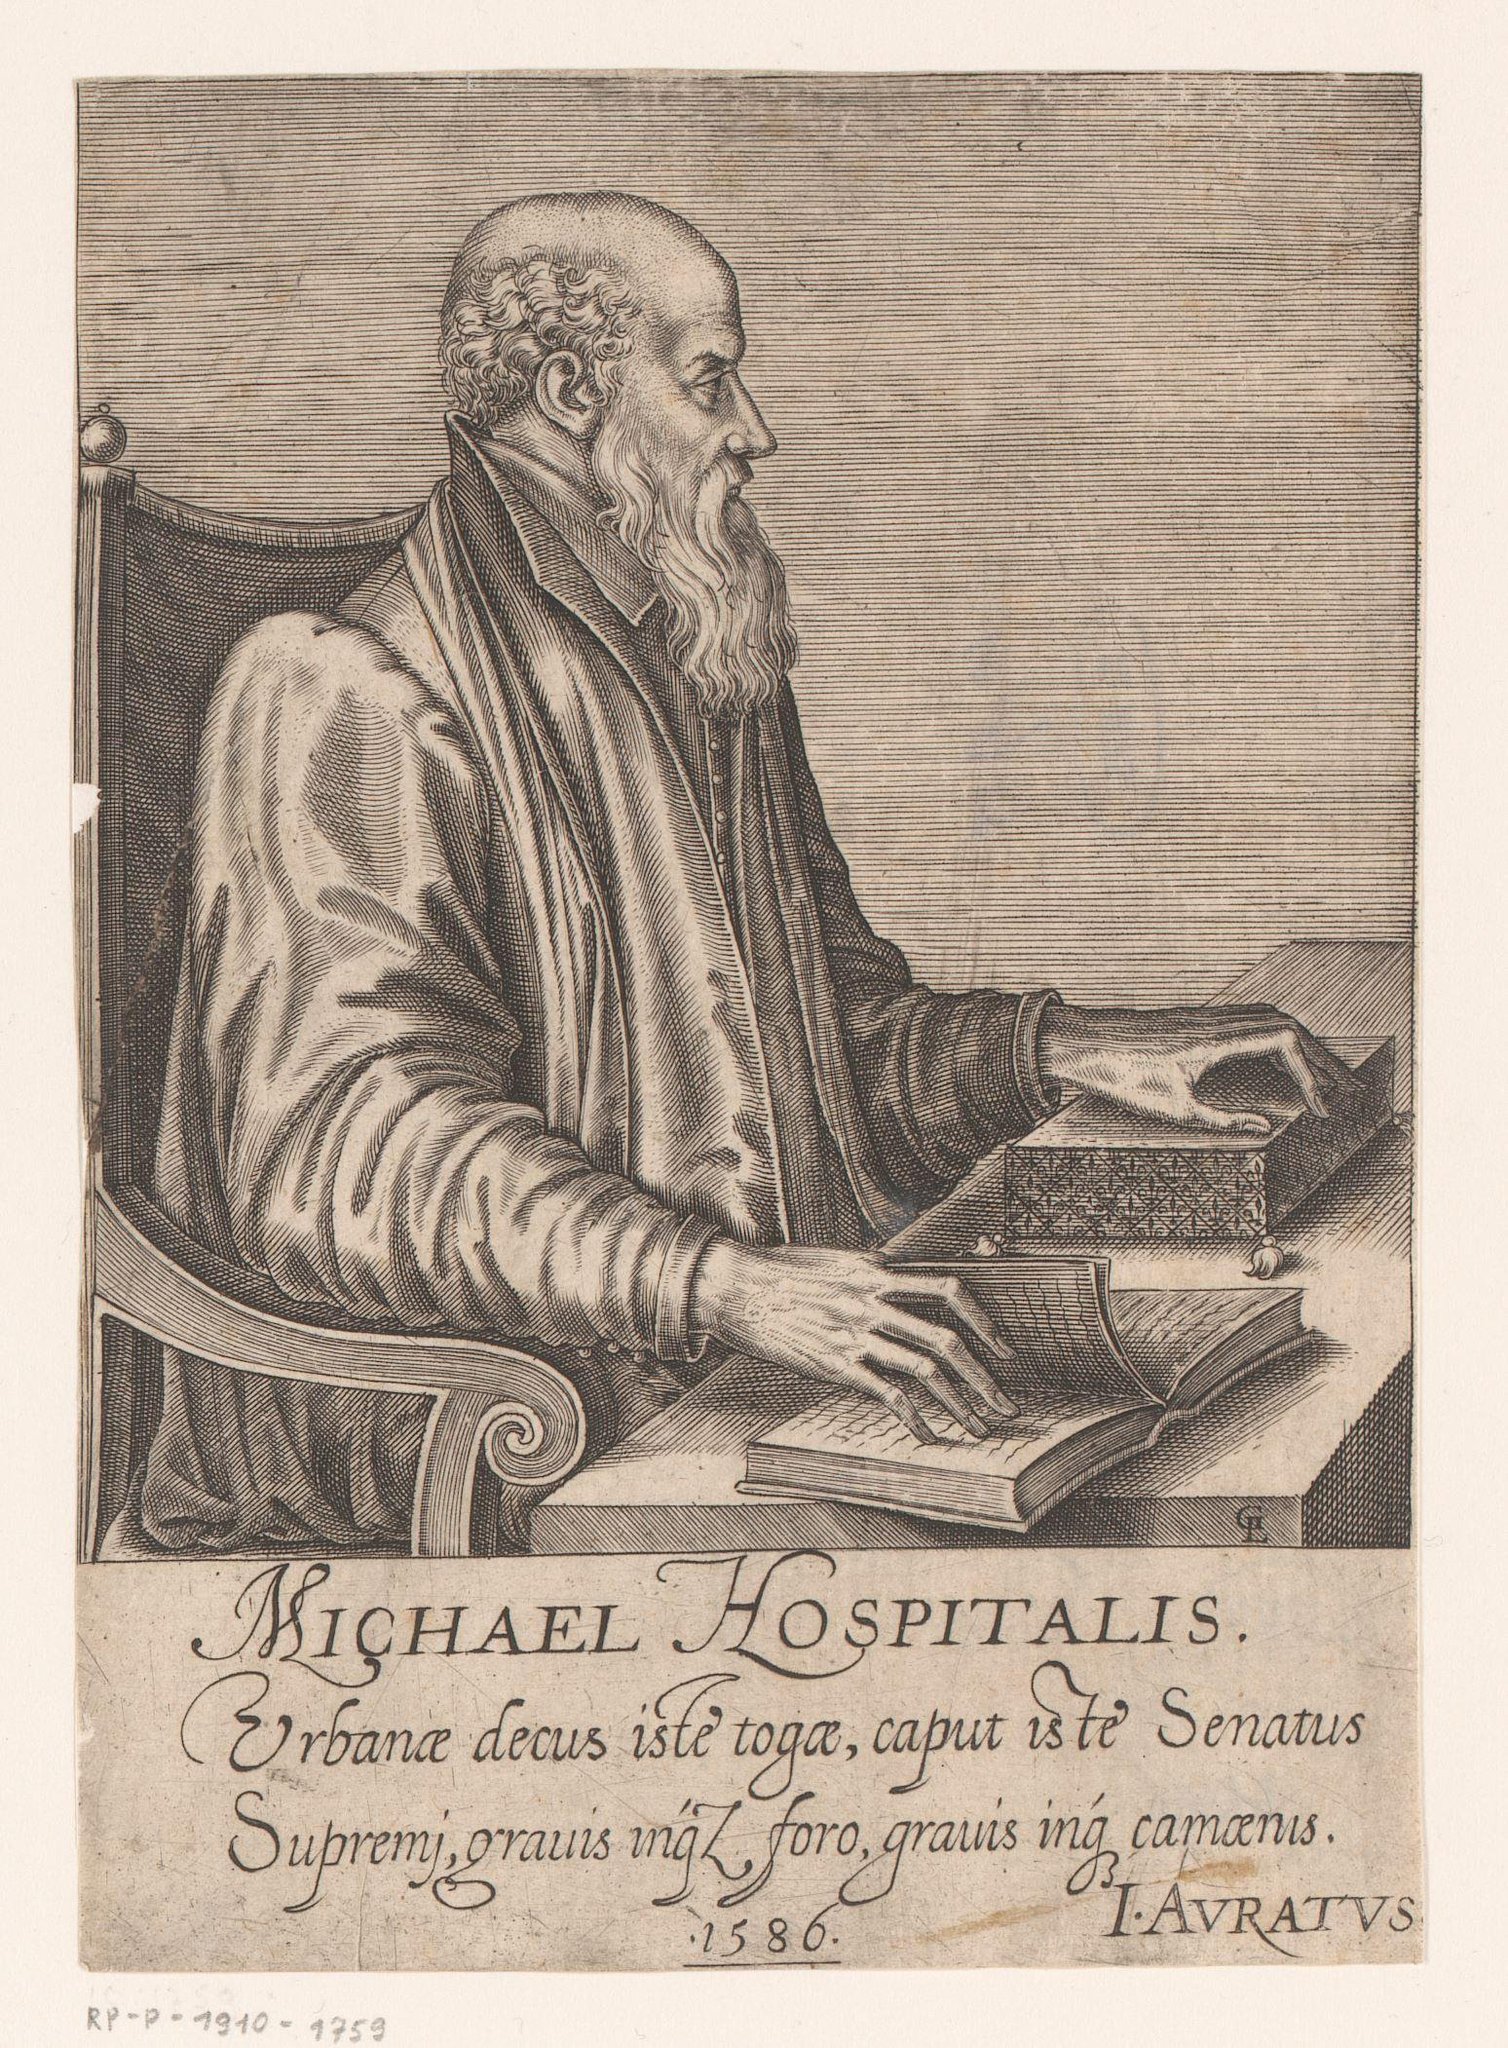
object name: print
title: Portret van Michel de l'Hospital aan zijn bureau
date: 1586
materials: paper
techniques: engraving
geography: france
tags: historical persons, book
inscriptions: collector's mark: Lugt 2228